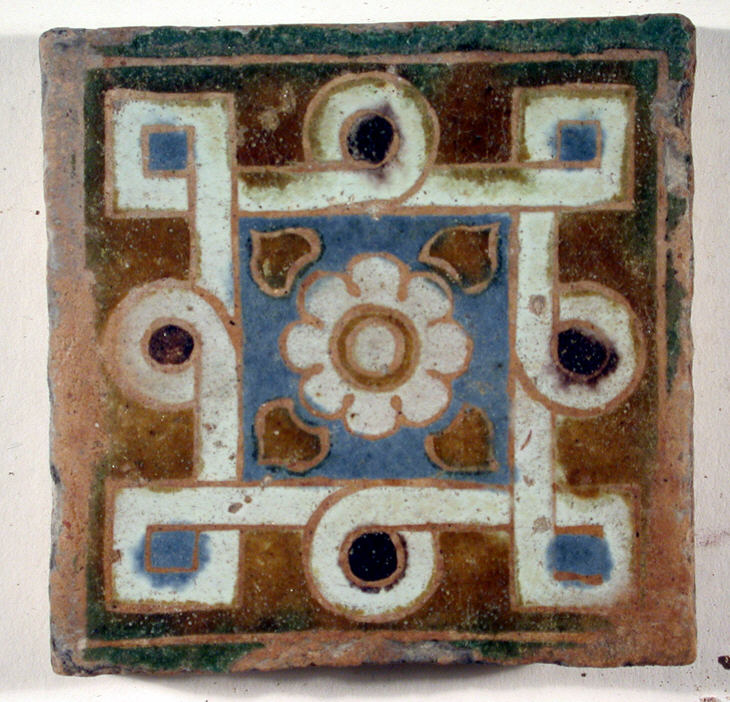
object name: pavement tile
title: Pavement tiles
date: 1501-1600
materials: earthenware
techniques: glazing